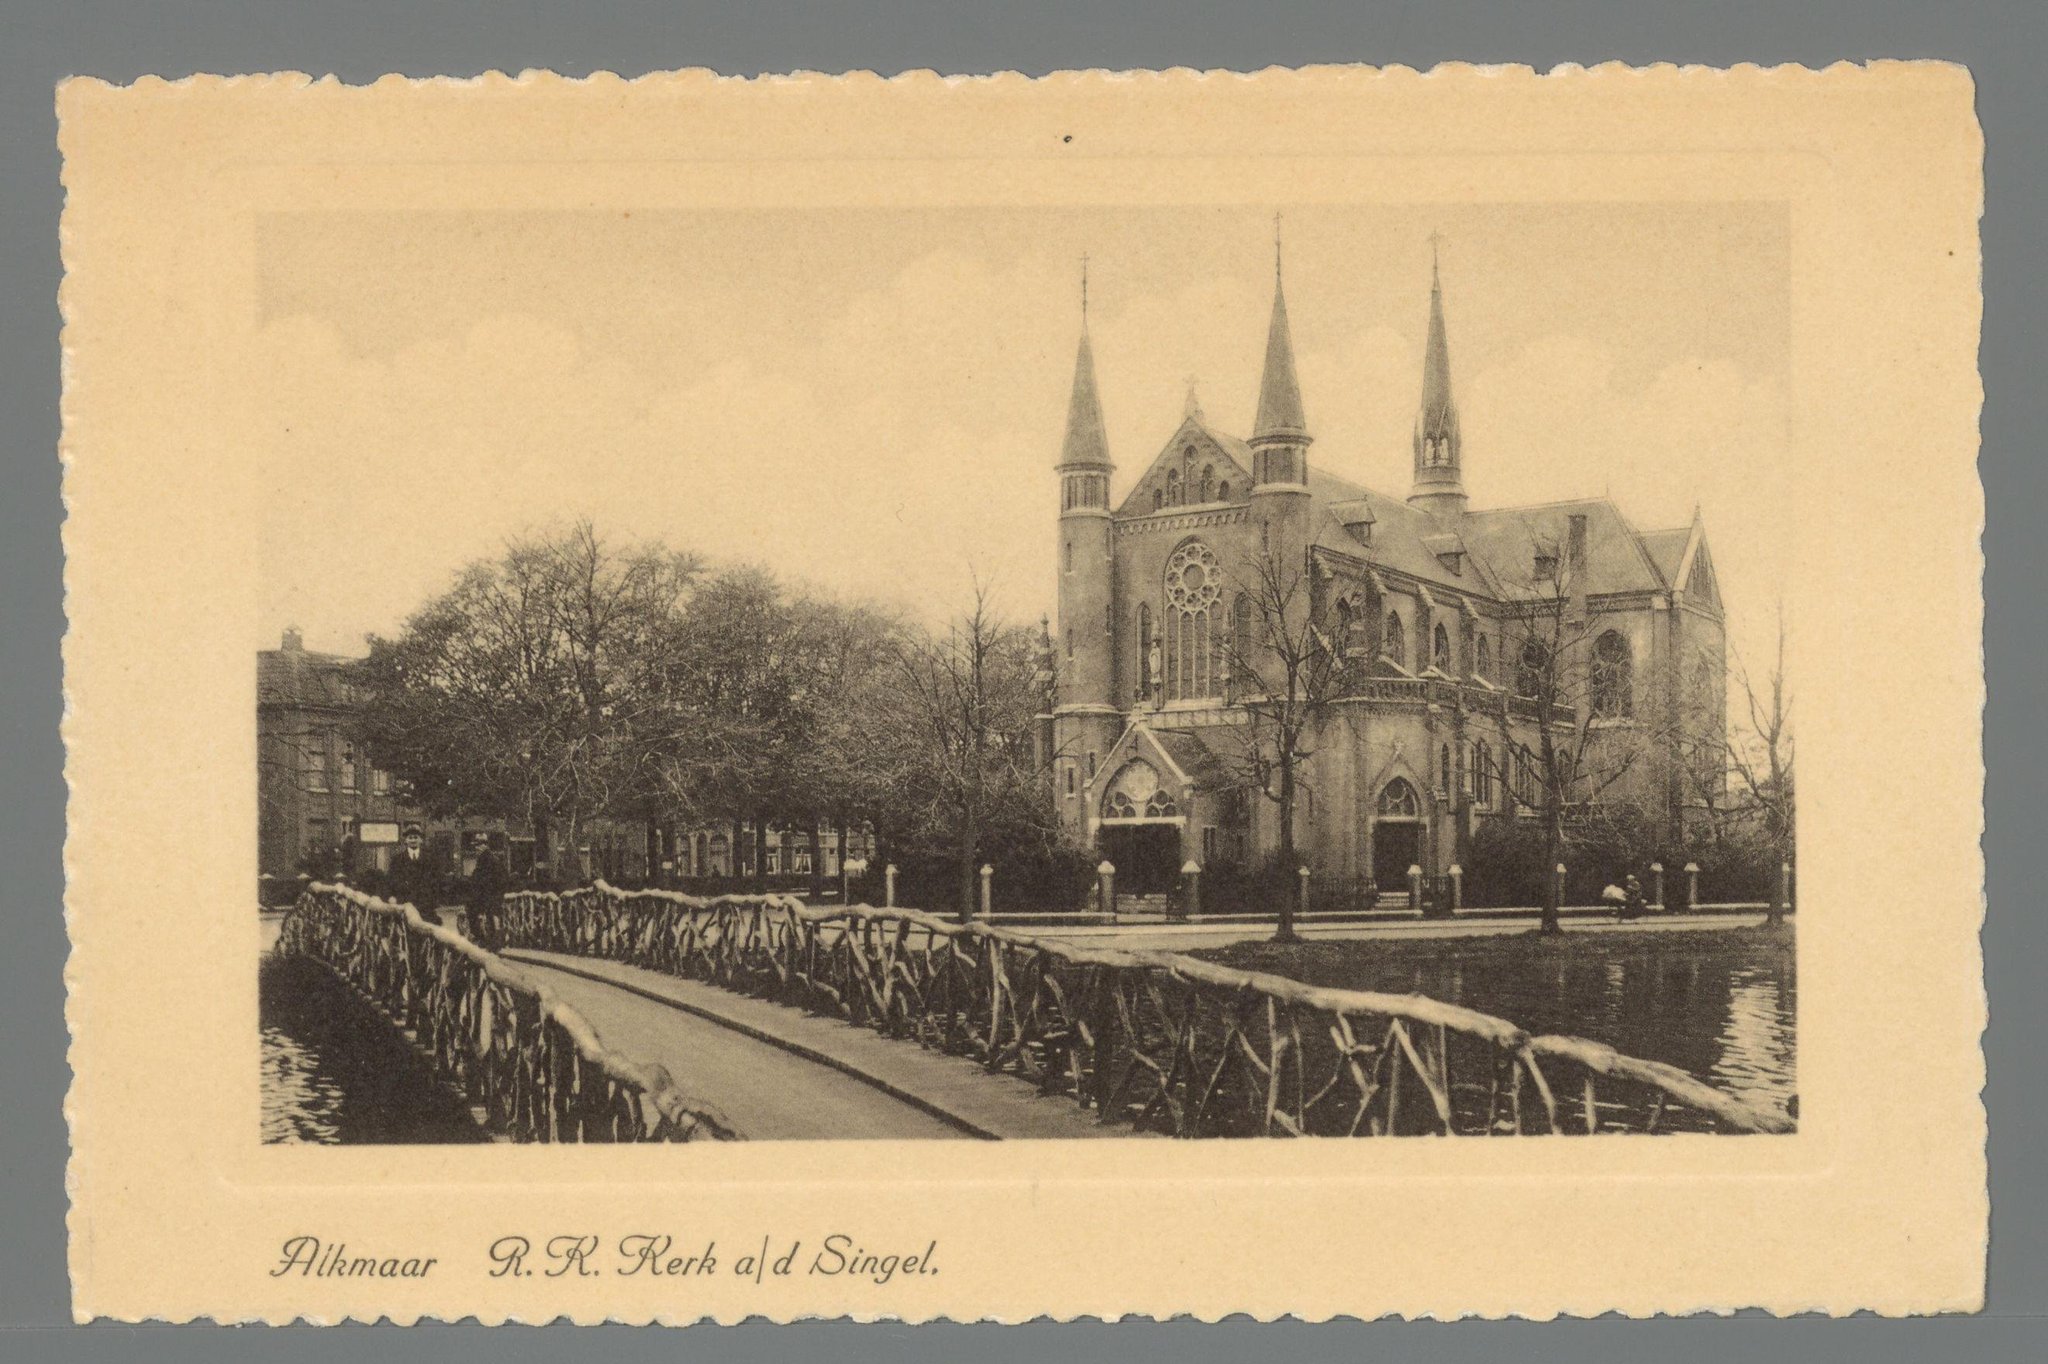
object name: photomechanical print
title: Alkmaar. R.K. Kerk a/d Singel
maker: Anonymous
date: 1921-1945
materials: cardboard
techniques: photograph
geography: utrecht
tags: church (exterior), bridge in city across river, canal, etc.